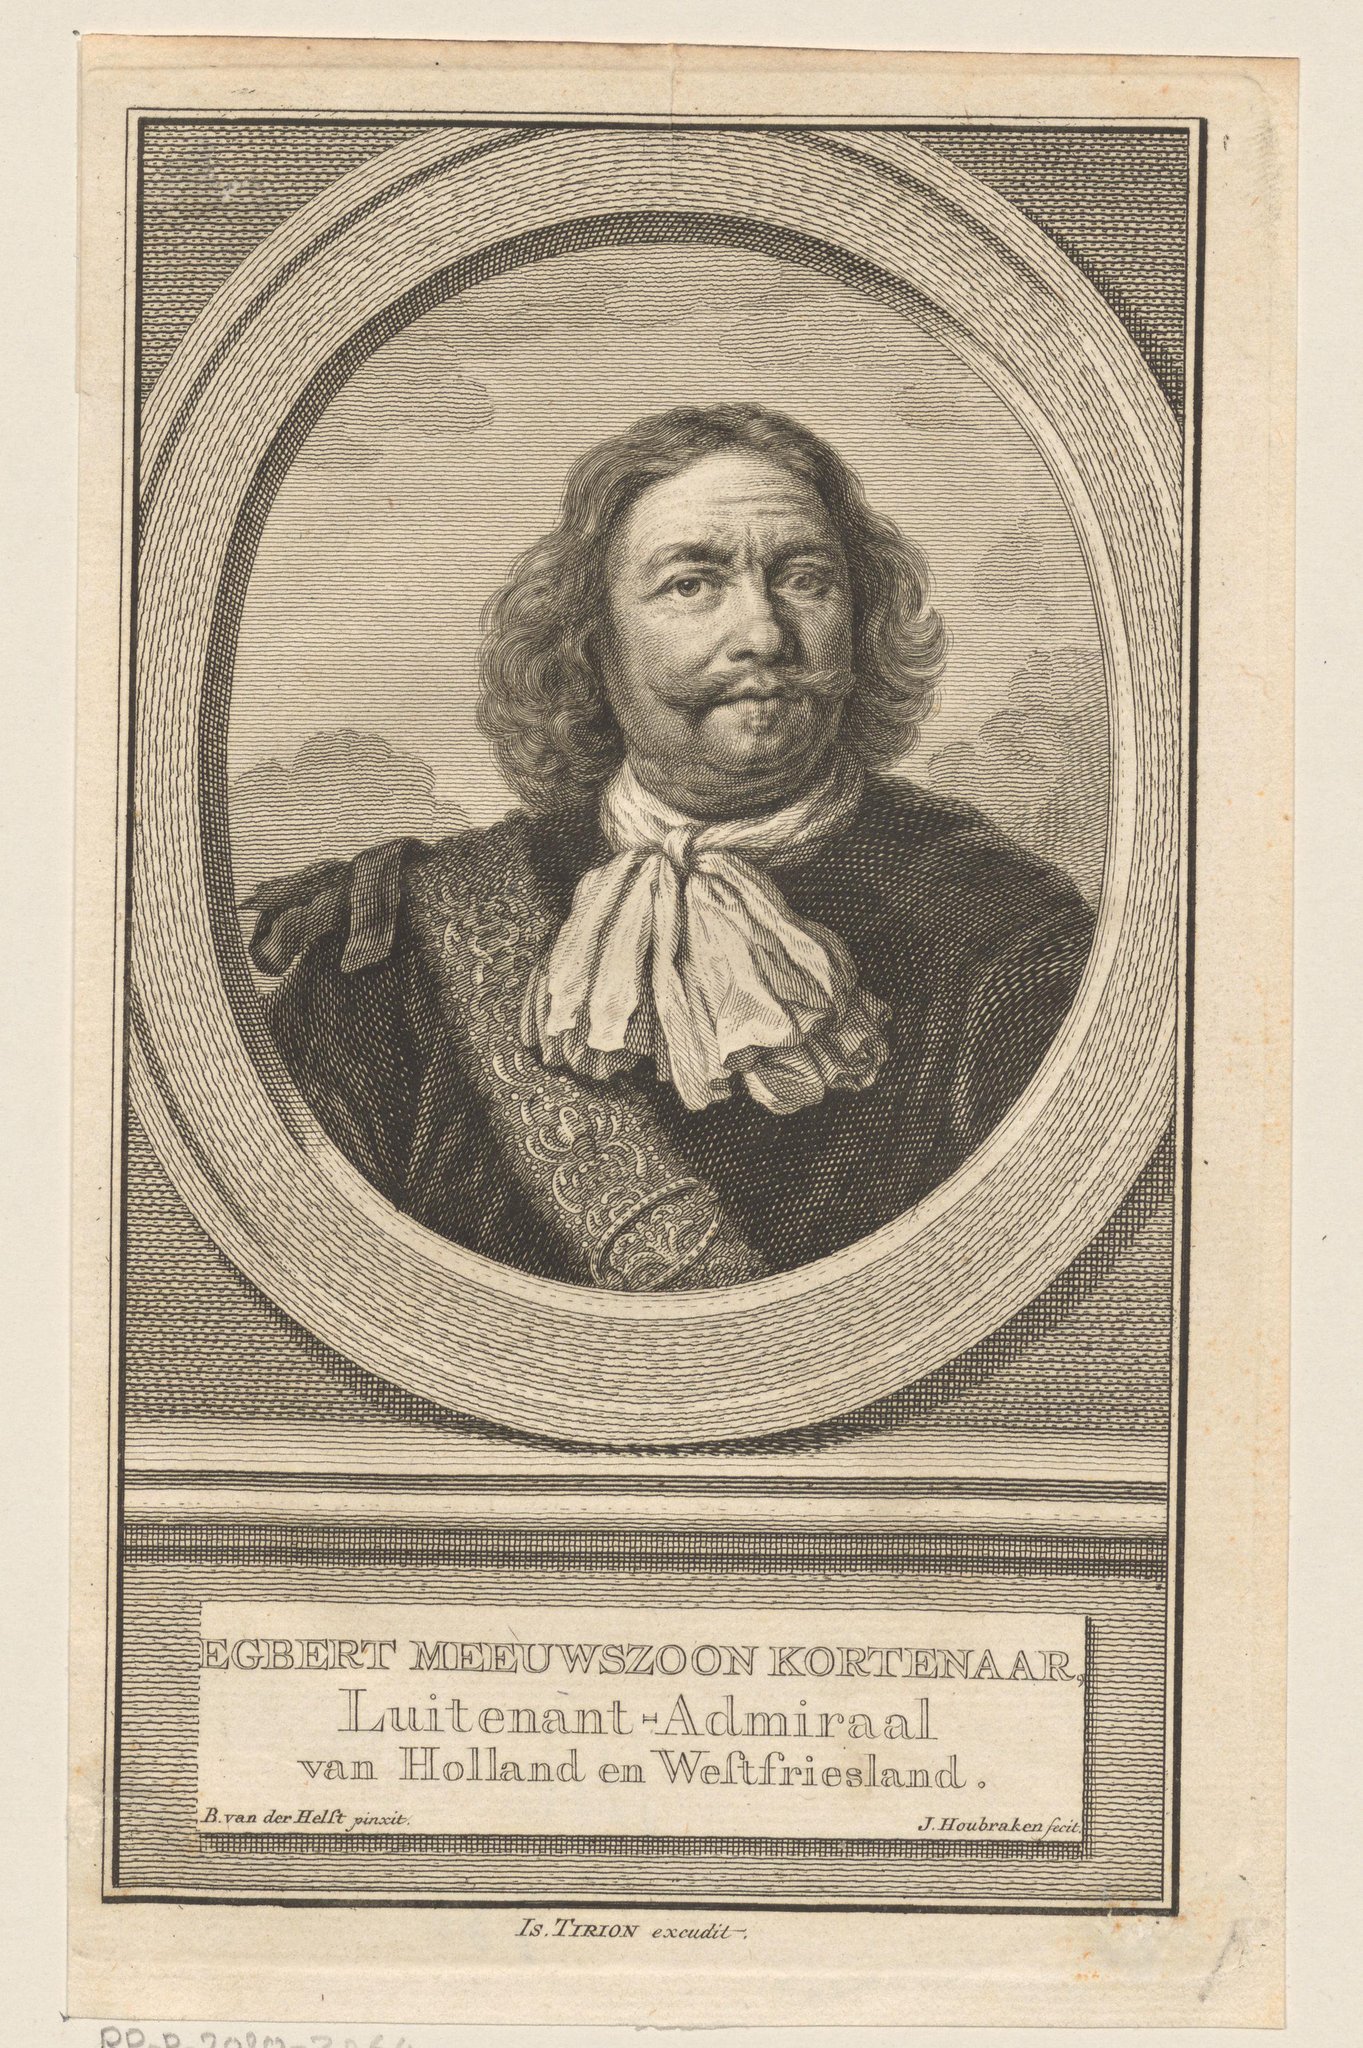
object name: print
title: Portret van Egbert Meeusz Kortenaer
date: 1749-1759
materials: paper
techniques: engraving, etching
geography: amsterdam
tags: historical persons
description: Prent ook gebruikt in: Wagenaar, Jan. Vaderlandsche historie, vervattende de geschiedenissen der nu Vereenigde Nederlanden, inzonderheid die van Holland (...). 21 dln. Amsterdam: Isaak Tirion, 1749-59.